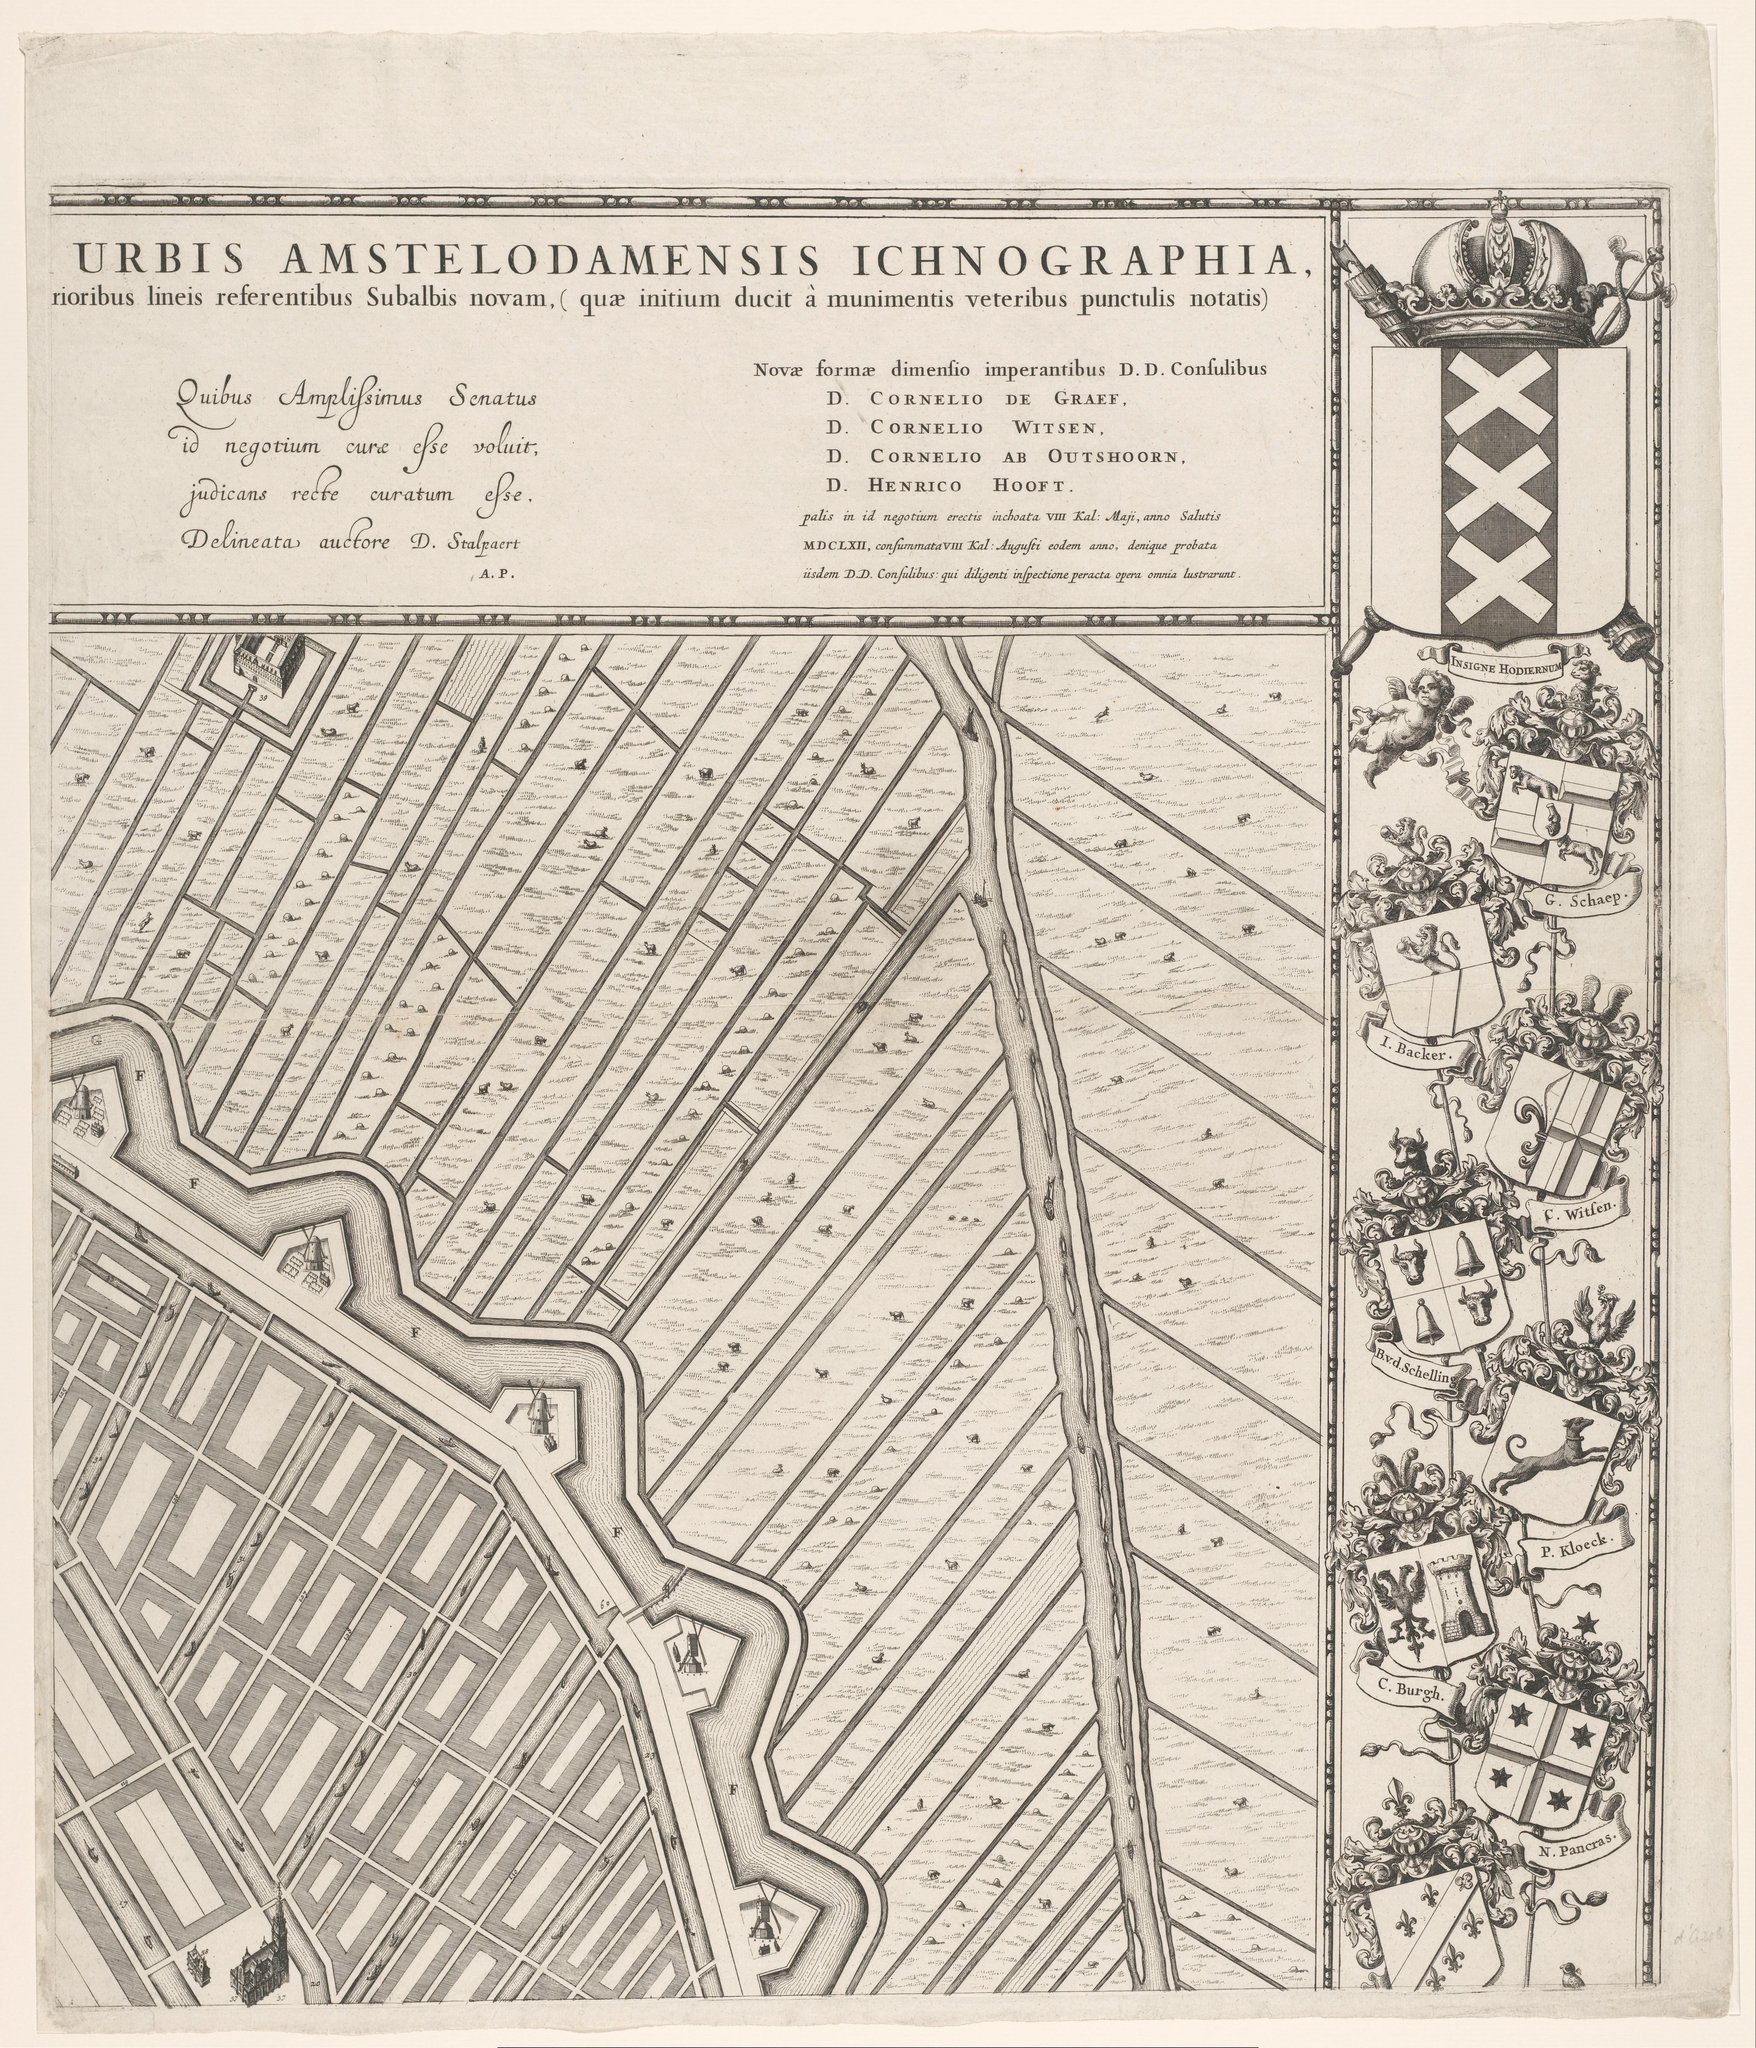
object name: area plan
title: Platte-grondt van de oude en nieuwe royinge der stede Amsterdam aengewesen met alle hare publike Gebouwen waer van de oude roying in 't bruyn en de nieuwe in 't bleeck wort uytgebeelt; de nieuwe begint daer de oude wal met gestipte linien is getekent / Veteris novaeque urbis Amstelodamensis ichnographia (…)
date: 1601-1663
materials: paper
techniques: engraving, etching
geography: amsterdam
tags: coat of arms (as symbol of the state, etc.) (+ city; municipal), maps of cities, armorial bearing, heraldry, amsterdam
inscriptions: collector's mark: Lugt 195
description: Derde deel van een plattegrond van Amsterdam met ontwerp en uitvoering van de Vierde Uitleg, bestaande uit zes delen. Rechtsonder genummerd: 3.